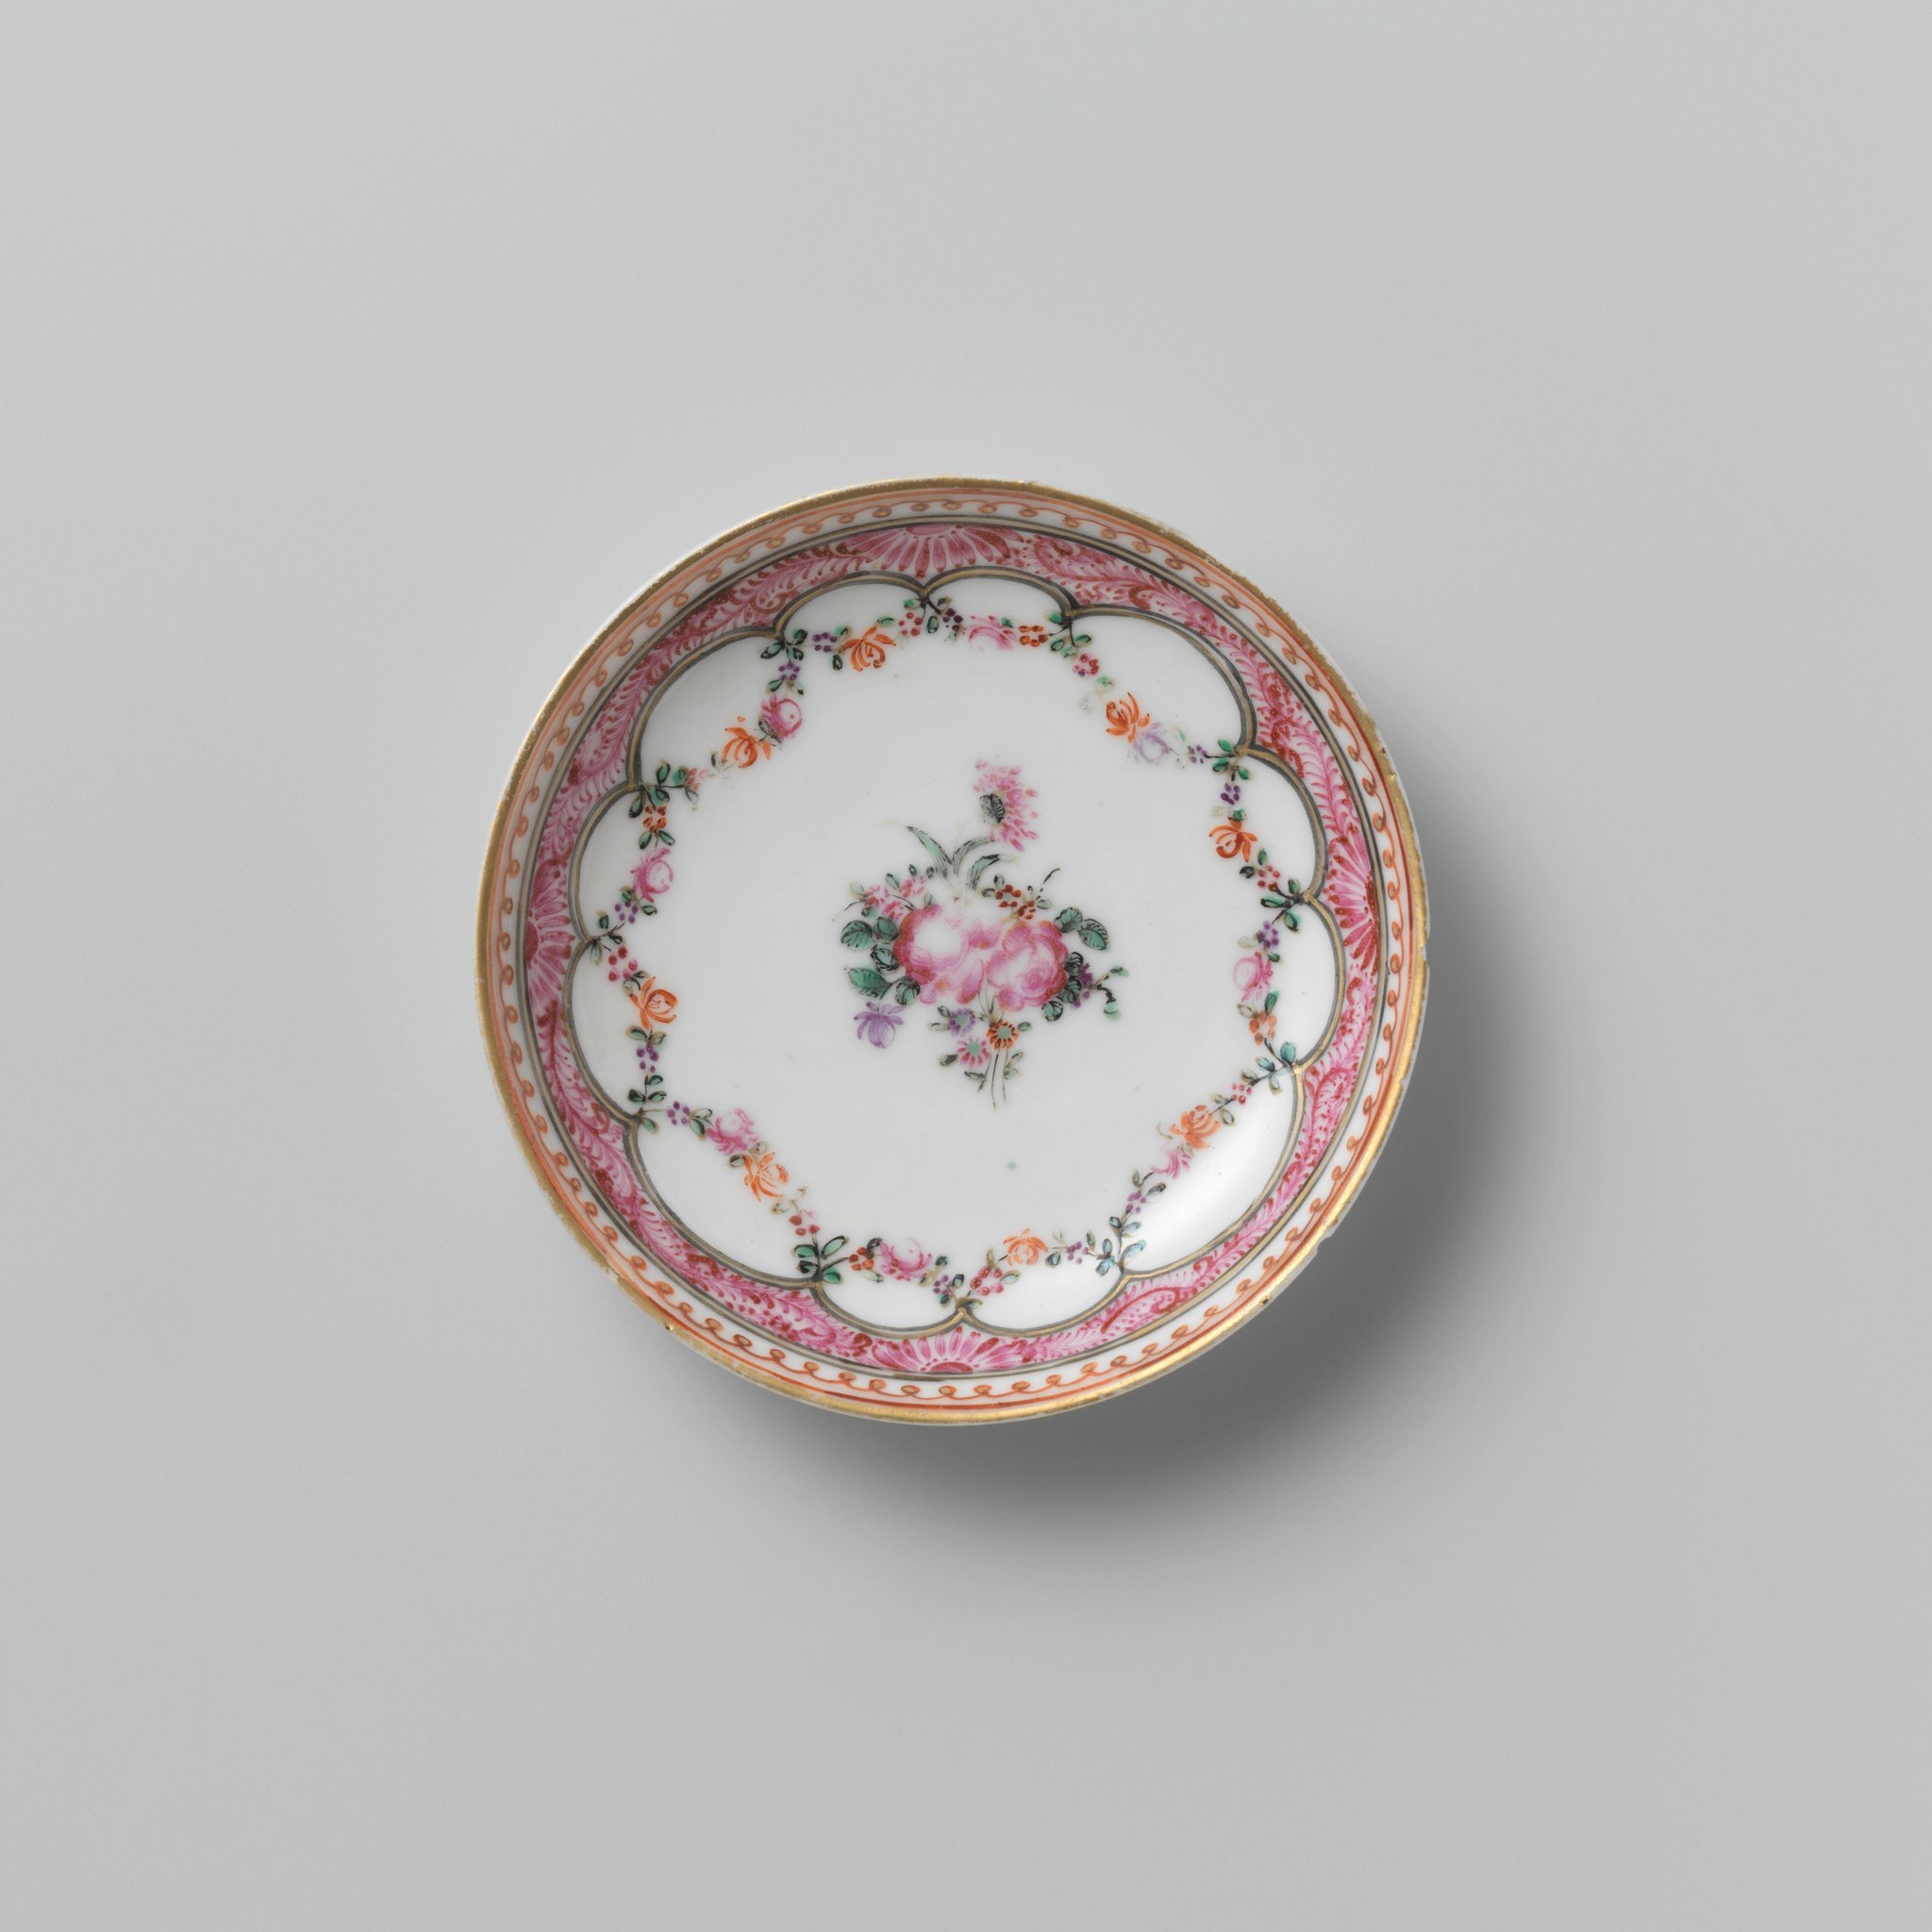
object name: kop en schotel, kop en schotel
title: Saucer with a flower group and garlands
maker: Anonymous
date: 1750-1774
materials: glaze, gold, paint, porcelain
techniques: firing, gilding, turning, vitrification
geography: china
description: Kop en schotel versierd in kleuren met bloemguirlandes.